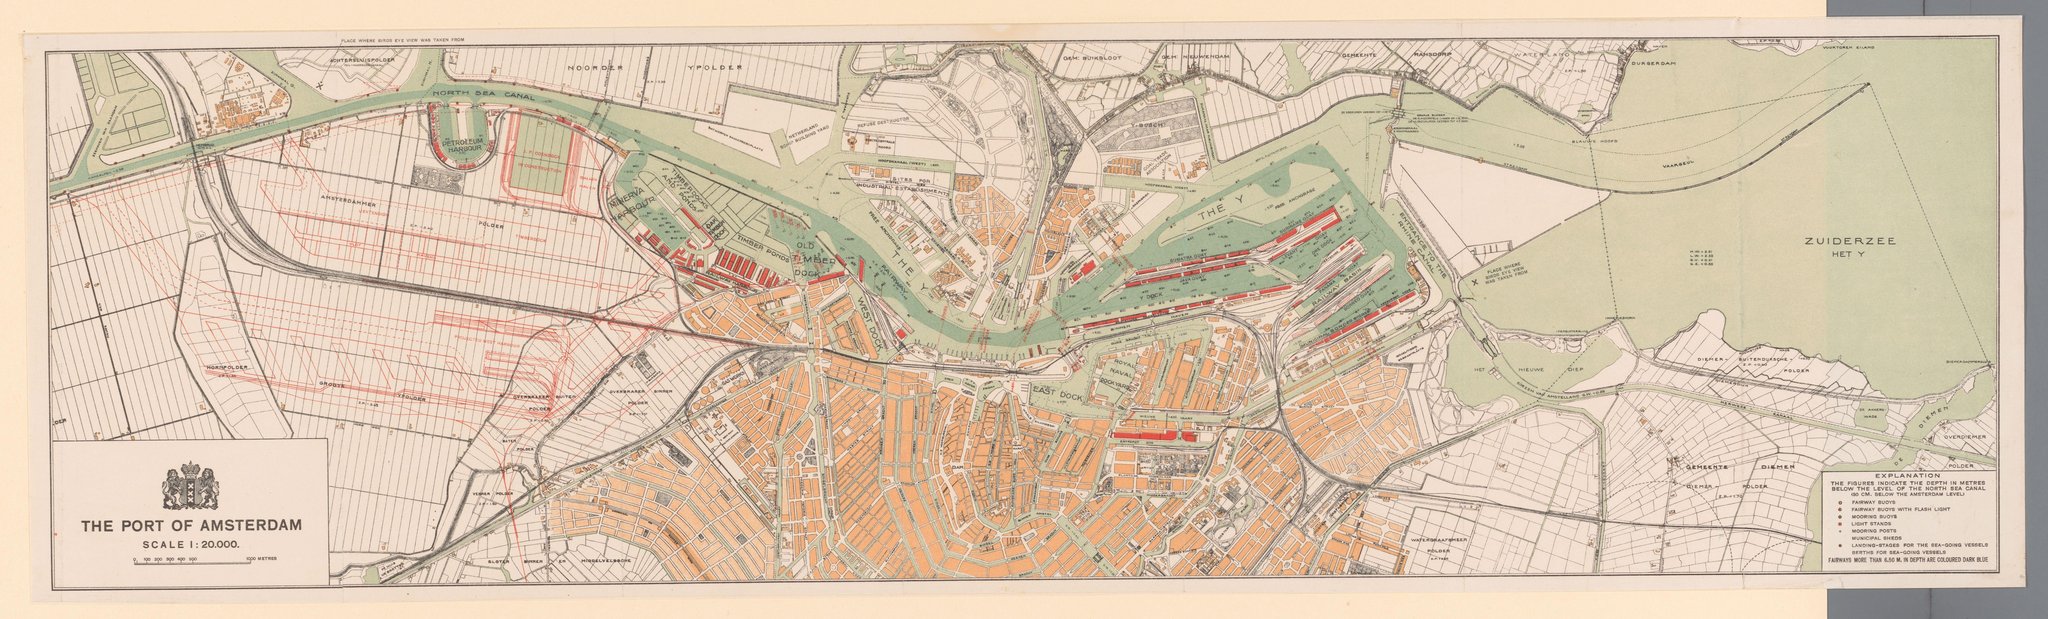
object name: area plan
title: Reproductie van een plattegrond van Amsterdam met de haven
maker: Anonymous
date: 1930-1935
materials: paper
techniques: photolithography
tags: maps of cities, amsterdam